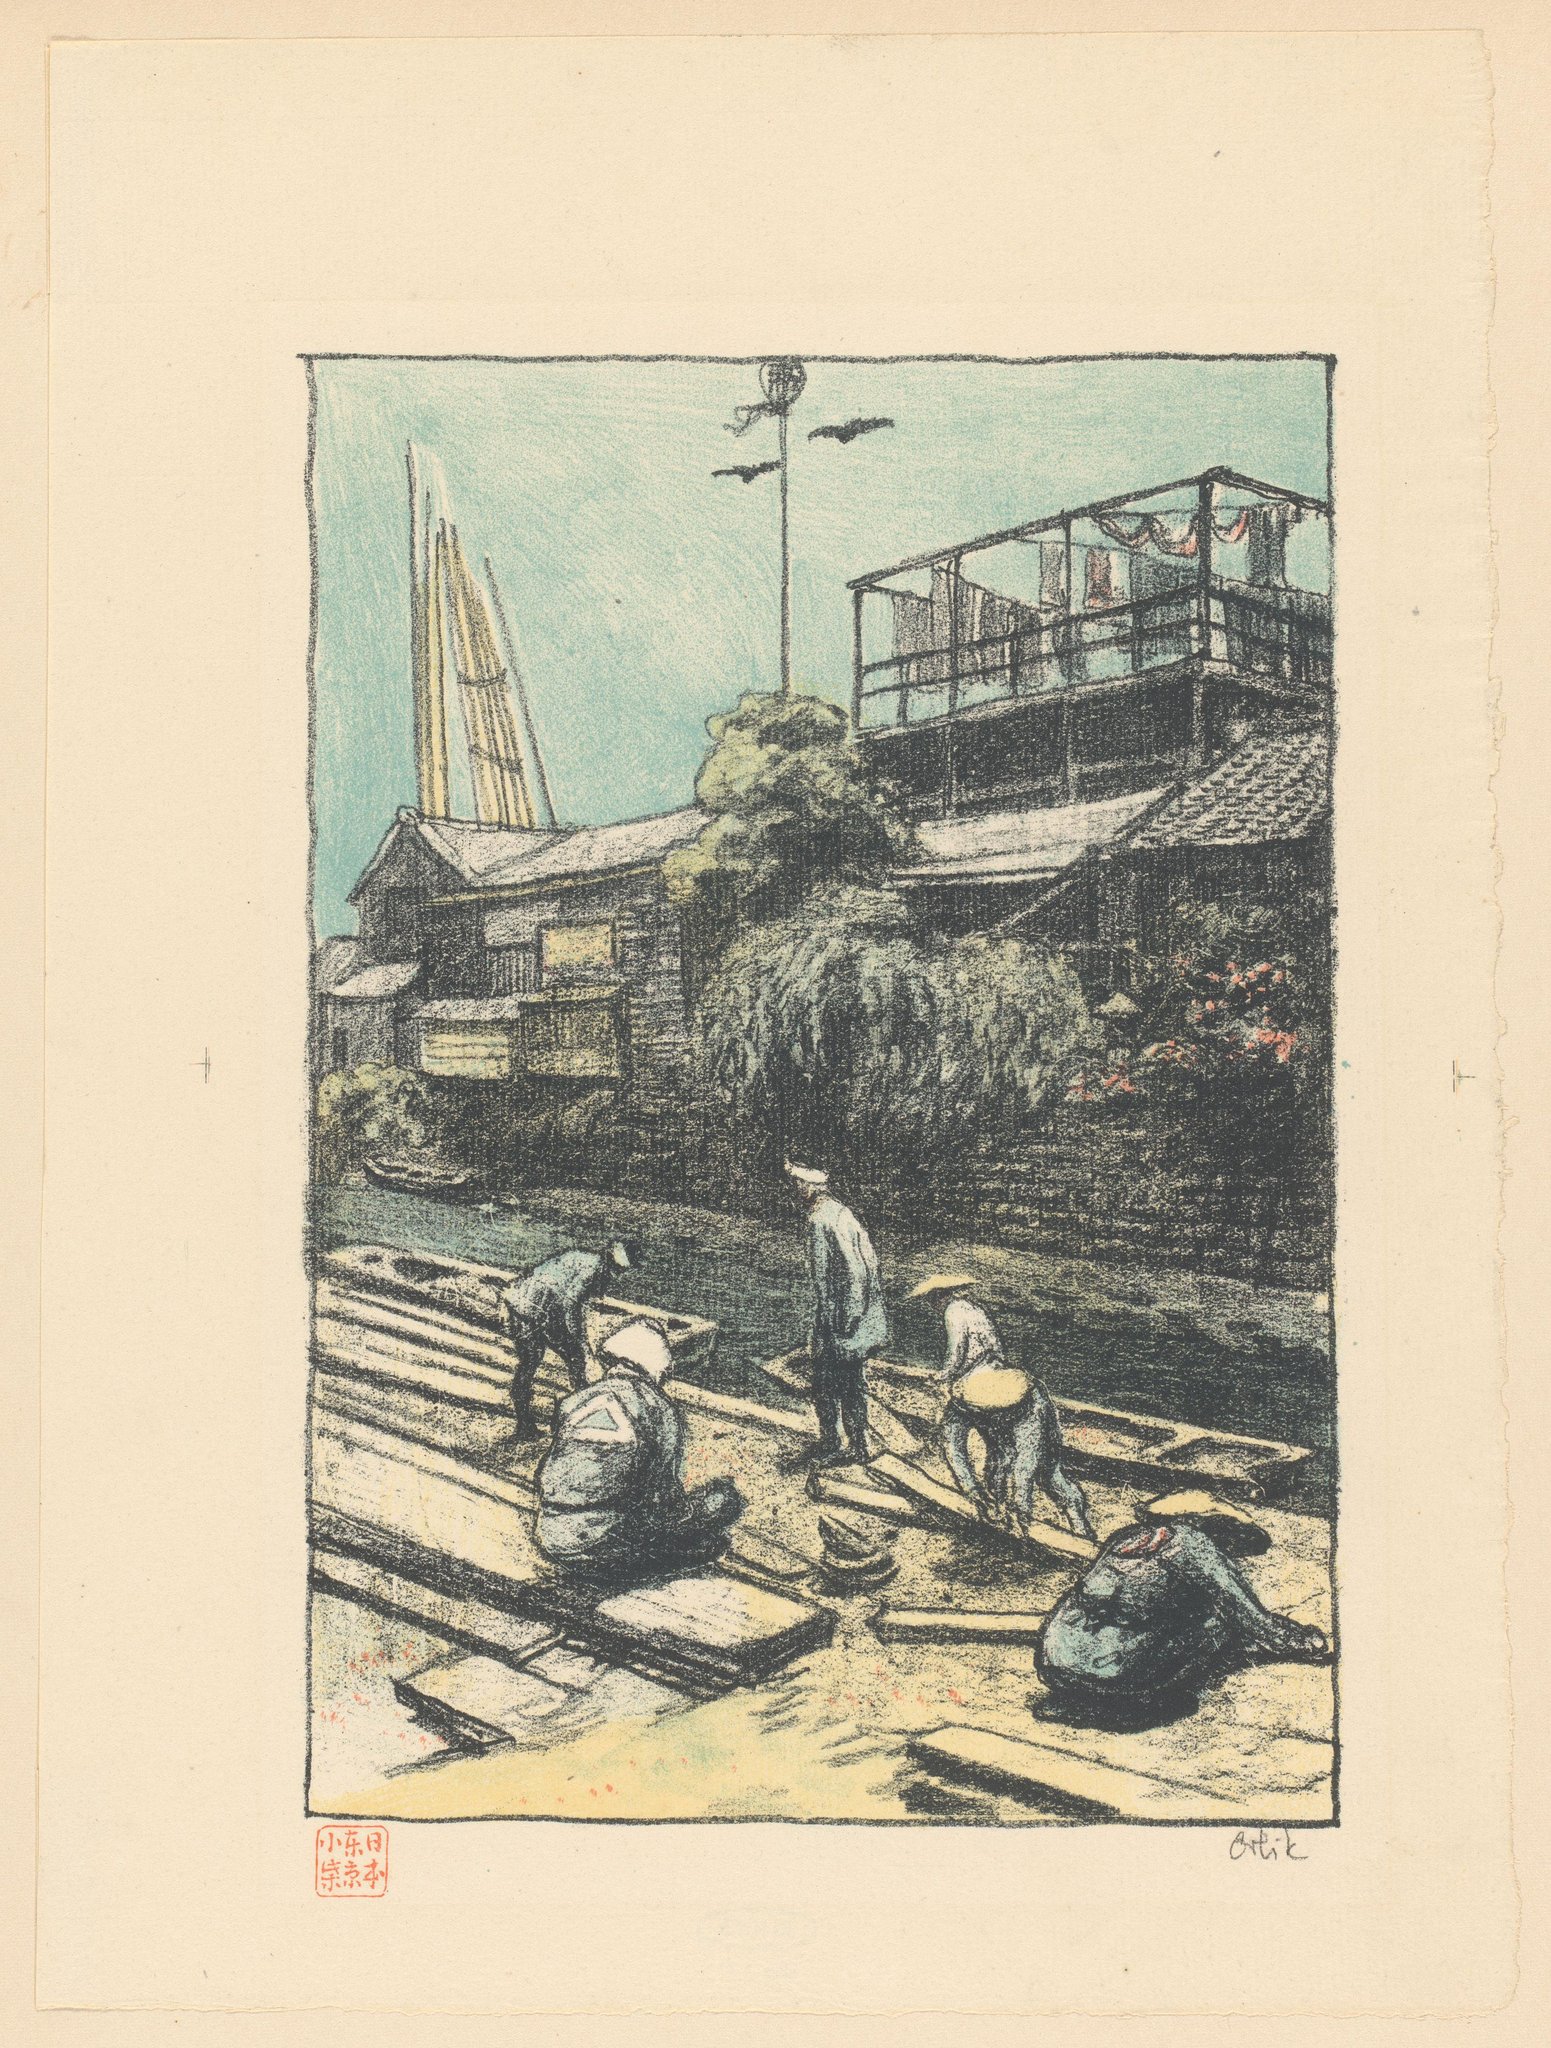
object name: print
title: Aus Japan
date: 1901-1903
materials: paper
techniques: lithograph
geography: tokyo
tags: carpenter, workshop, japan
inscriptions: workshop stamp: ‘Nihon Tokyo Koshiba’, collector's mark: Lugt 2228